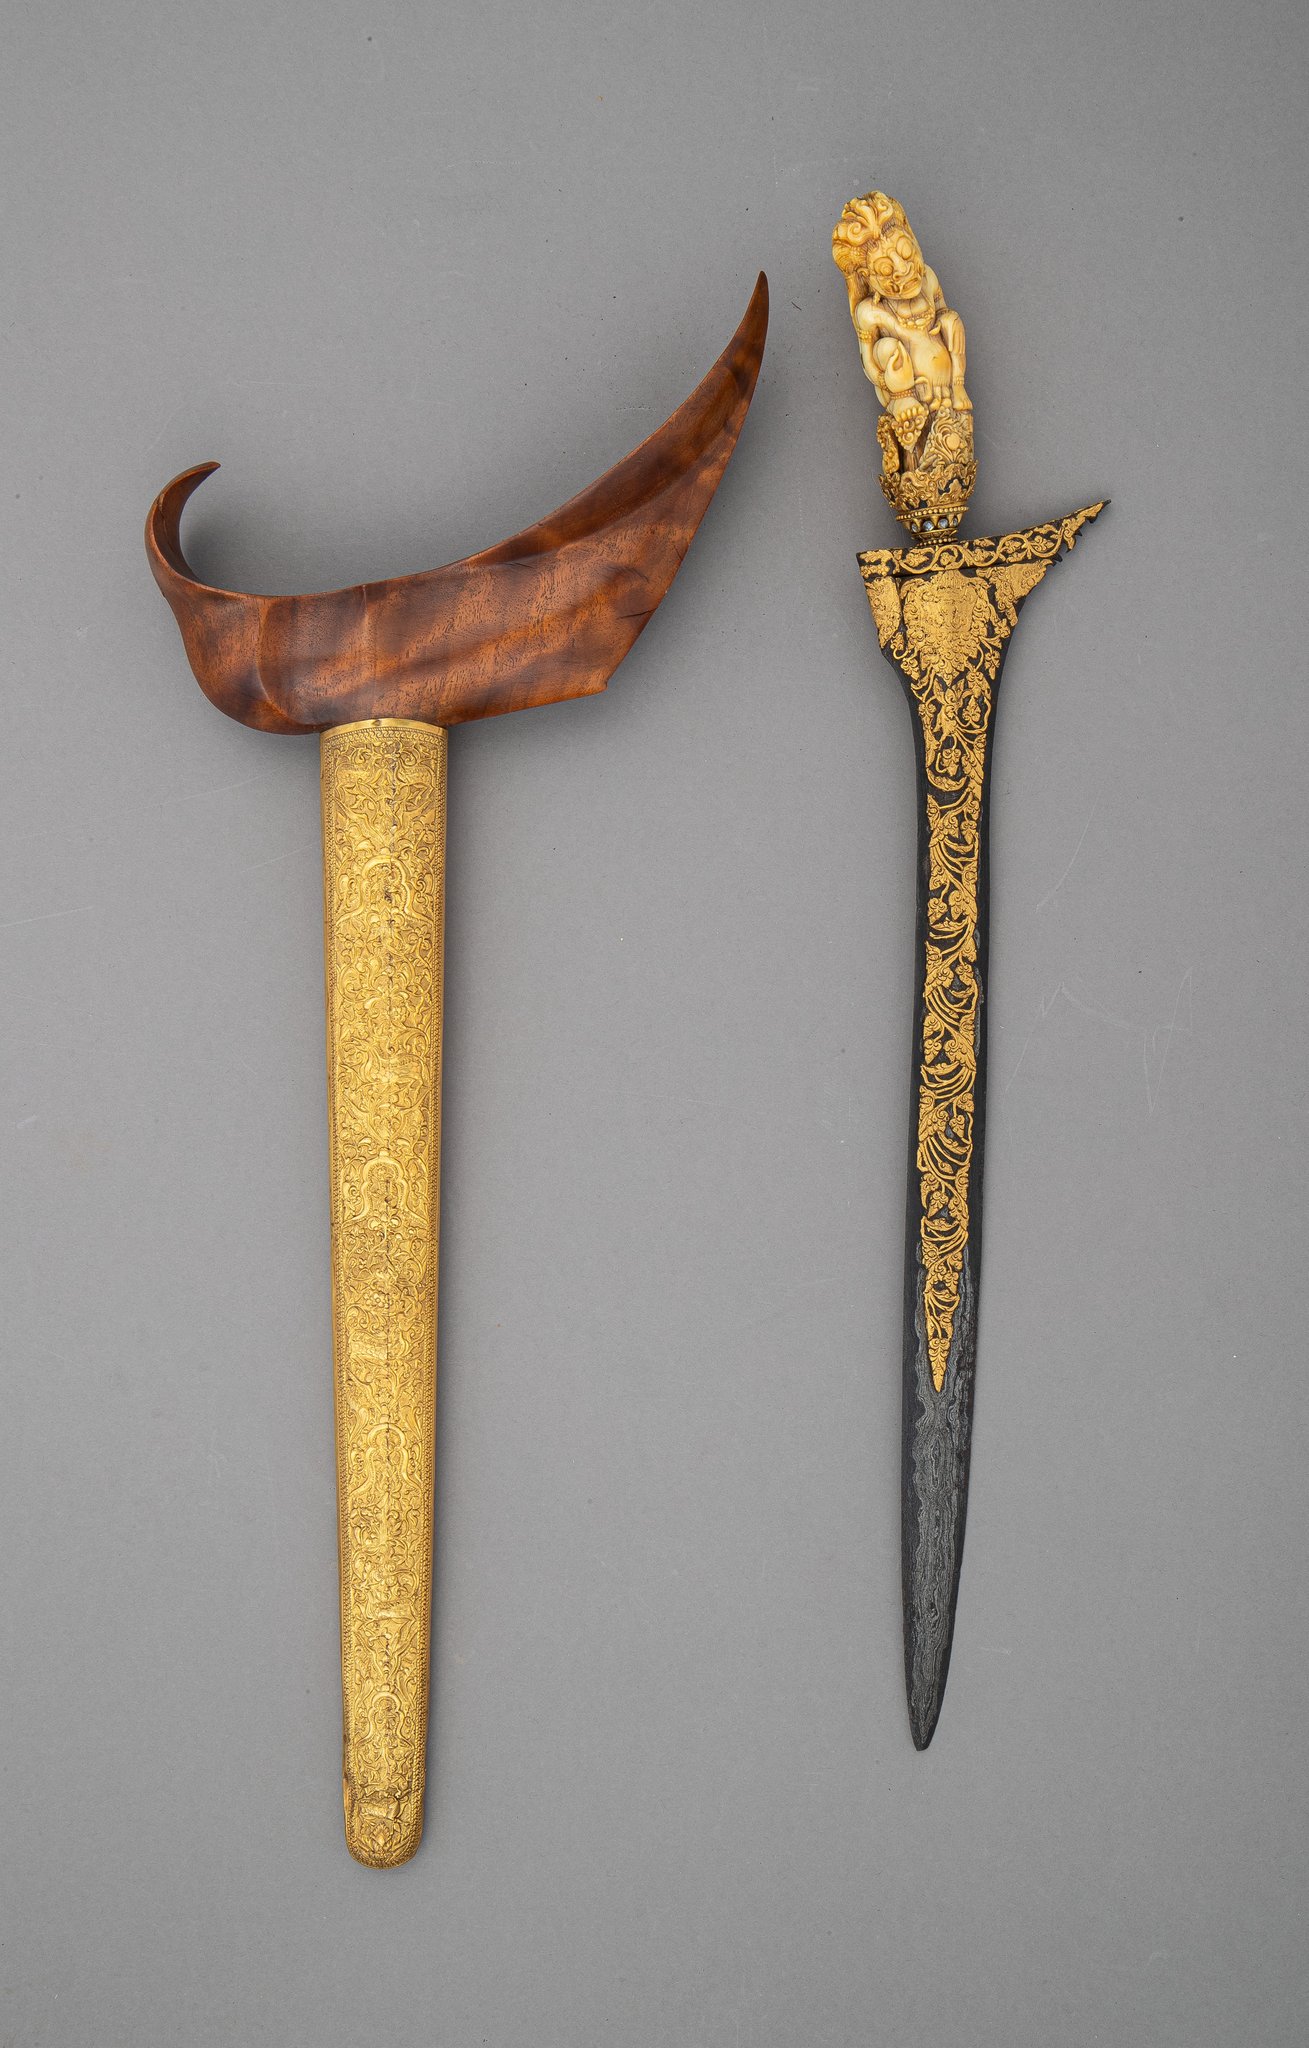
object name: kris with sheath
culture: javanese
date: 1701-1800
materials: diamond, gold, ivory, steel, wood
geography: indonesia